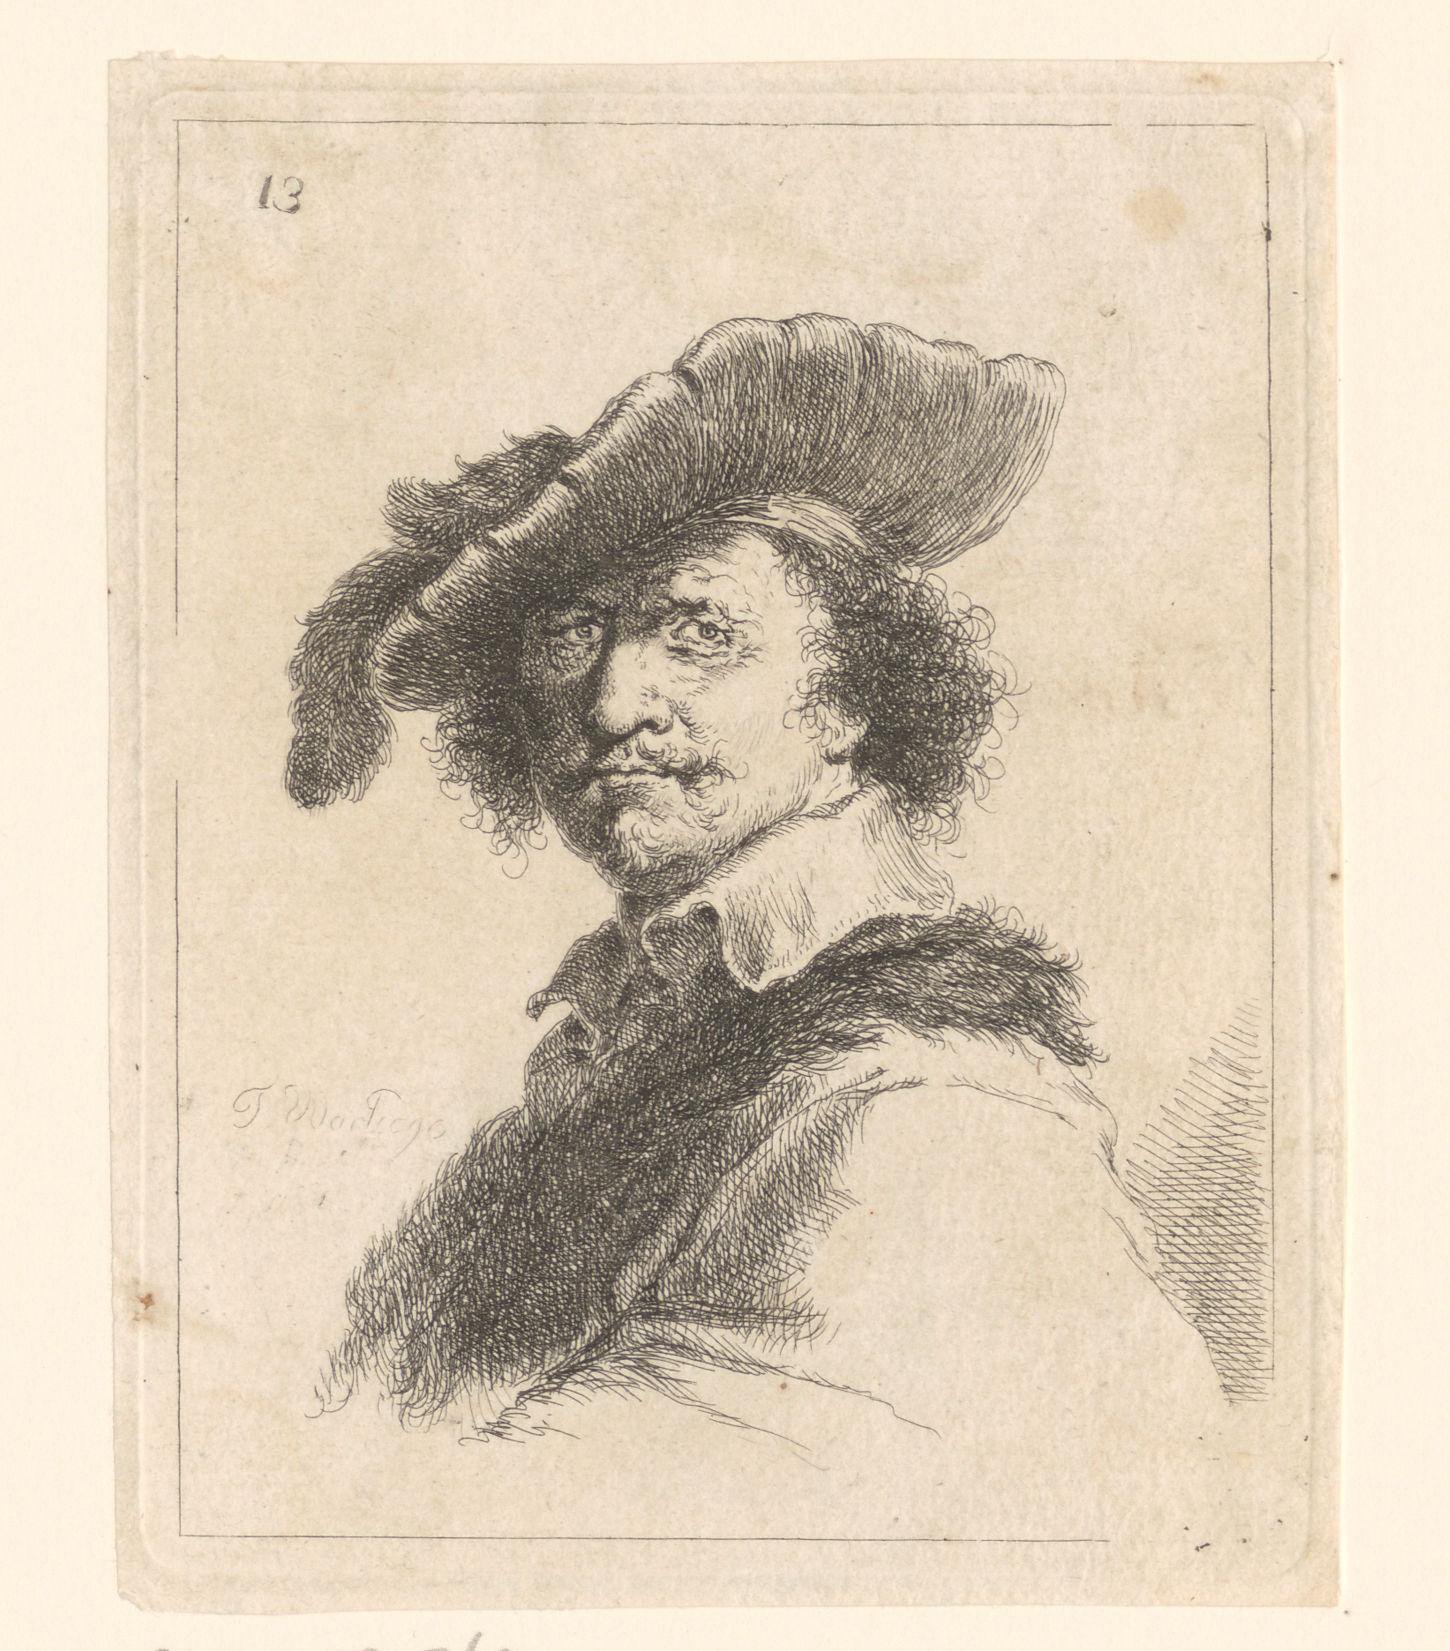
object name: print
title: Portret van Rembrandt van Rijn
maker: thomas worlidge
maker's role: print maker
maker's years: 1700-1766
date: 1710-1766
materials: paper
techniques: etching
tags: amsterdam, draughtsman, rembrandt van rijn, historical persons, portrait, self-portrait of painter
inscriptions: collector's mark: Lugt 2228, collector's mark: Lugt 2760